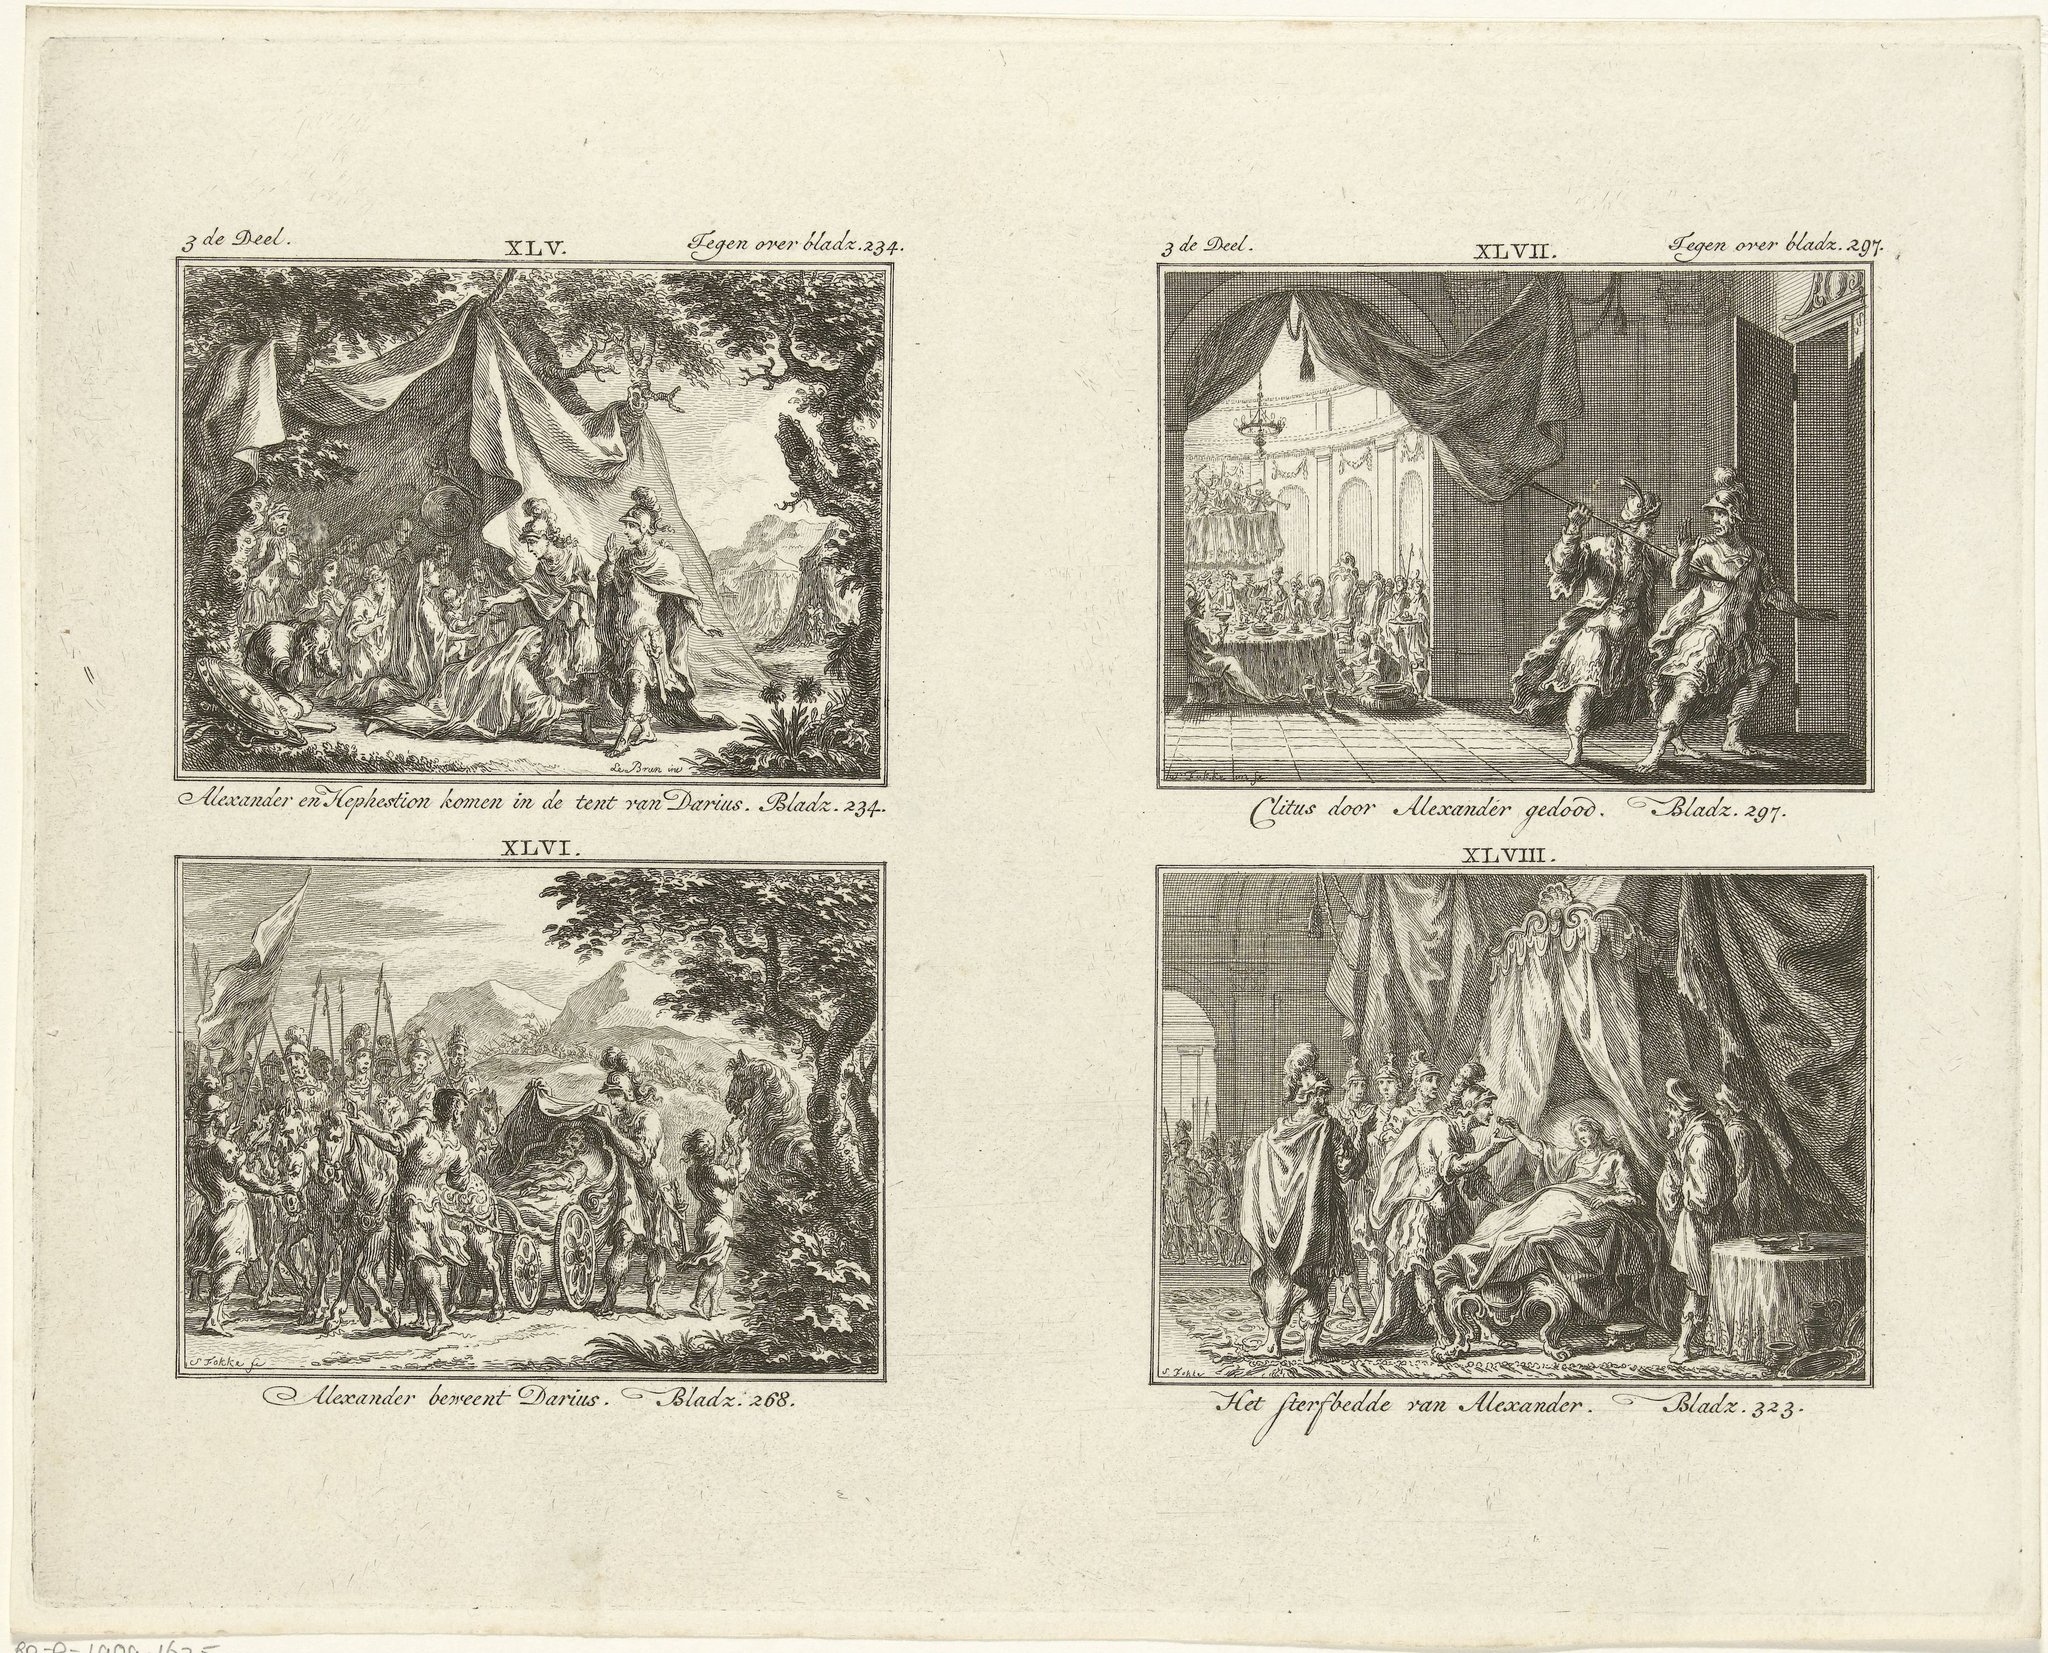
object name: print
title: Illustraties uit de klassieke geschiedenis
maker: simon fokke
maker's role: draughtsman, print maker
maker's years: 1712-1784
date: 1722-1784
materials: paper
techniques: etching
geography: amsterdam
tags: darius' family kneels before alexander, who requests sisigambis, darius' mother, to rise, death of alexander: alexander on his deathbed, at a feast alexander kills his friend clitus with a javelin, alexander covers darius' body with his own mantle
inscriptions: collector's mark: Lugt 2228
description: Vier voorstellingen uit de klassieke geschiedenis van één plaat, genummerd van XLV tot en met XLVIII en alle voorzien van een onderschrift. Linksboven: Alexander en Hephestion in de tent van Darius. Linksonder: Alexander beweent Darius. Rechtsboven: Clitus door Alexander gedood. Rechtsonder: Sterfbed van Alexander. Voorstellingen XLV en XLVI rechtsboven gemerkt: Tegen over bladz. 234. Voorstellingen XLVII en XLVIII rechtsboven gemerkt: Tegen over bladz. 297.